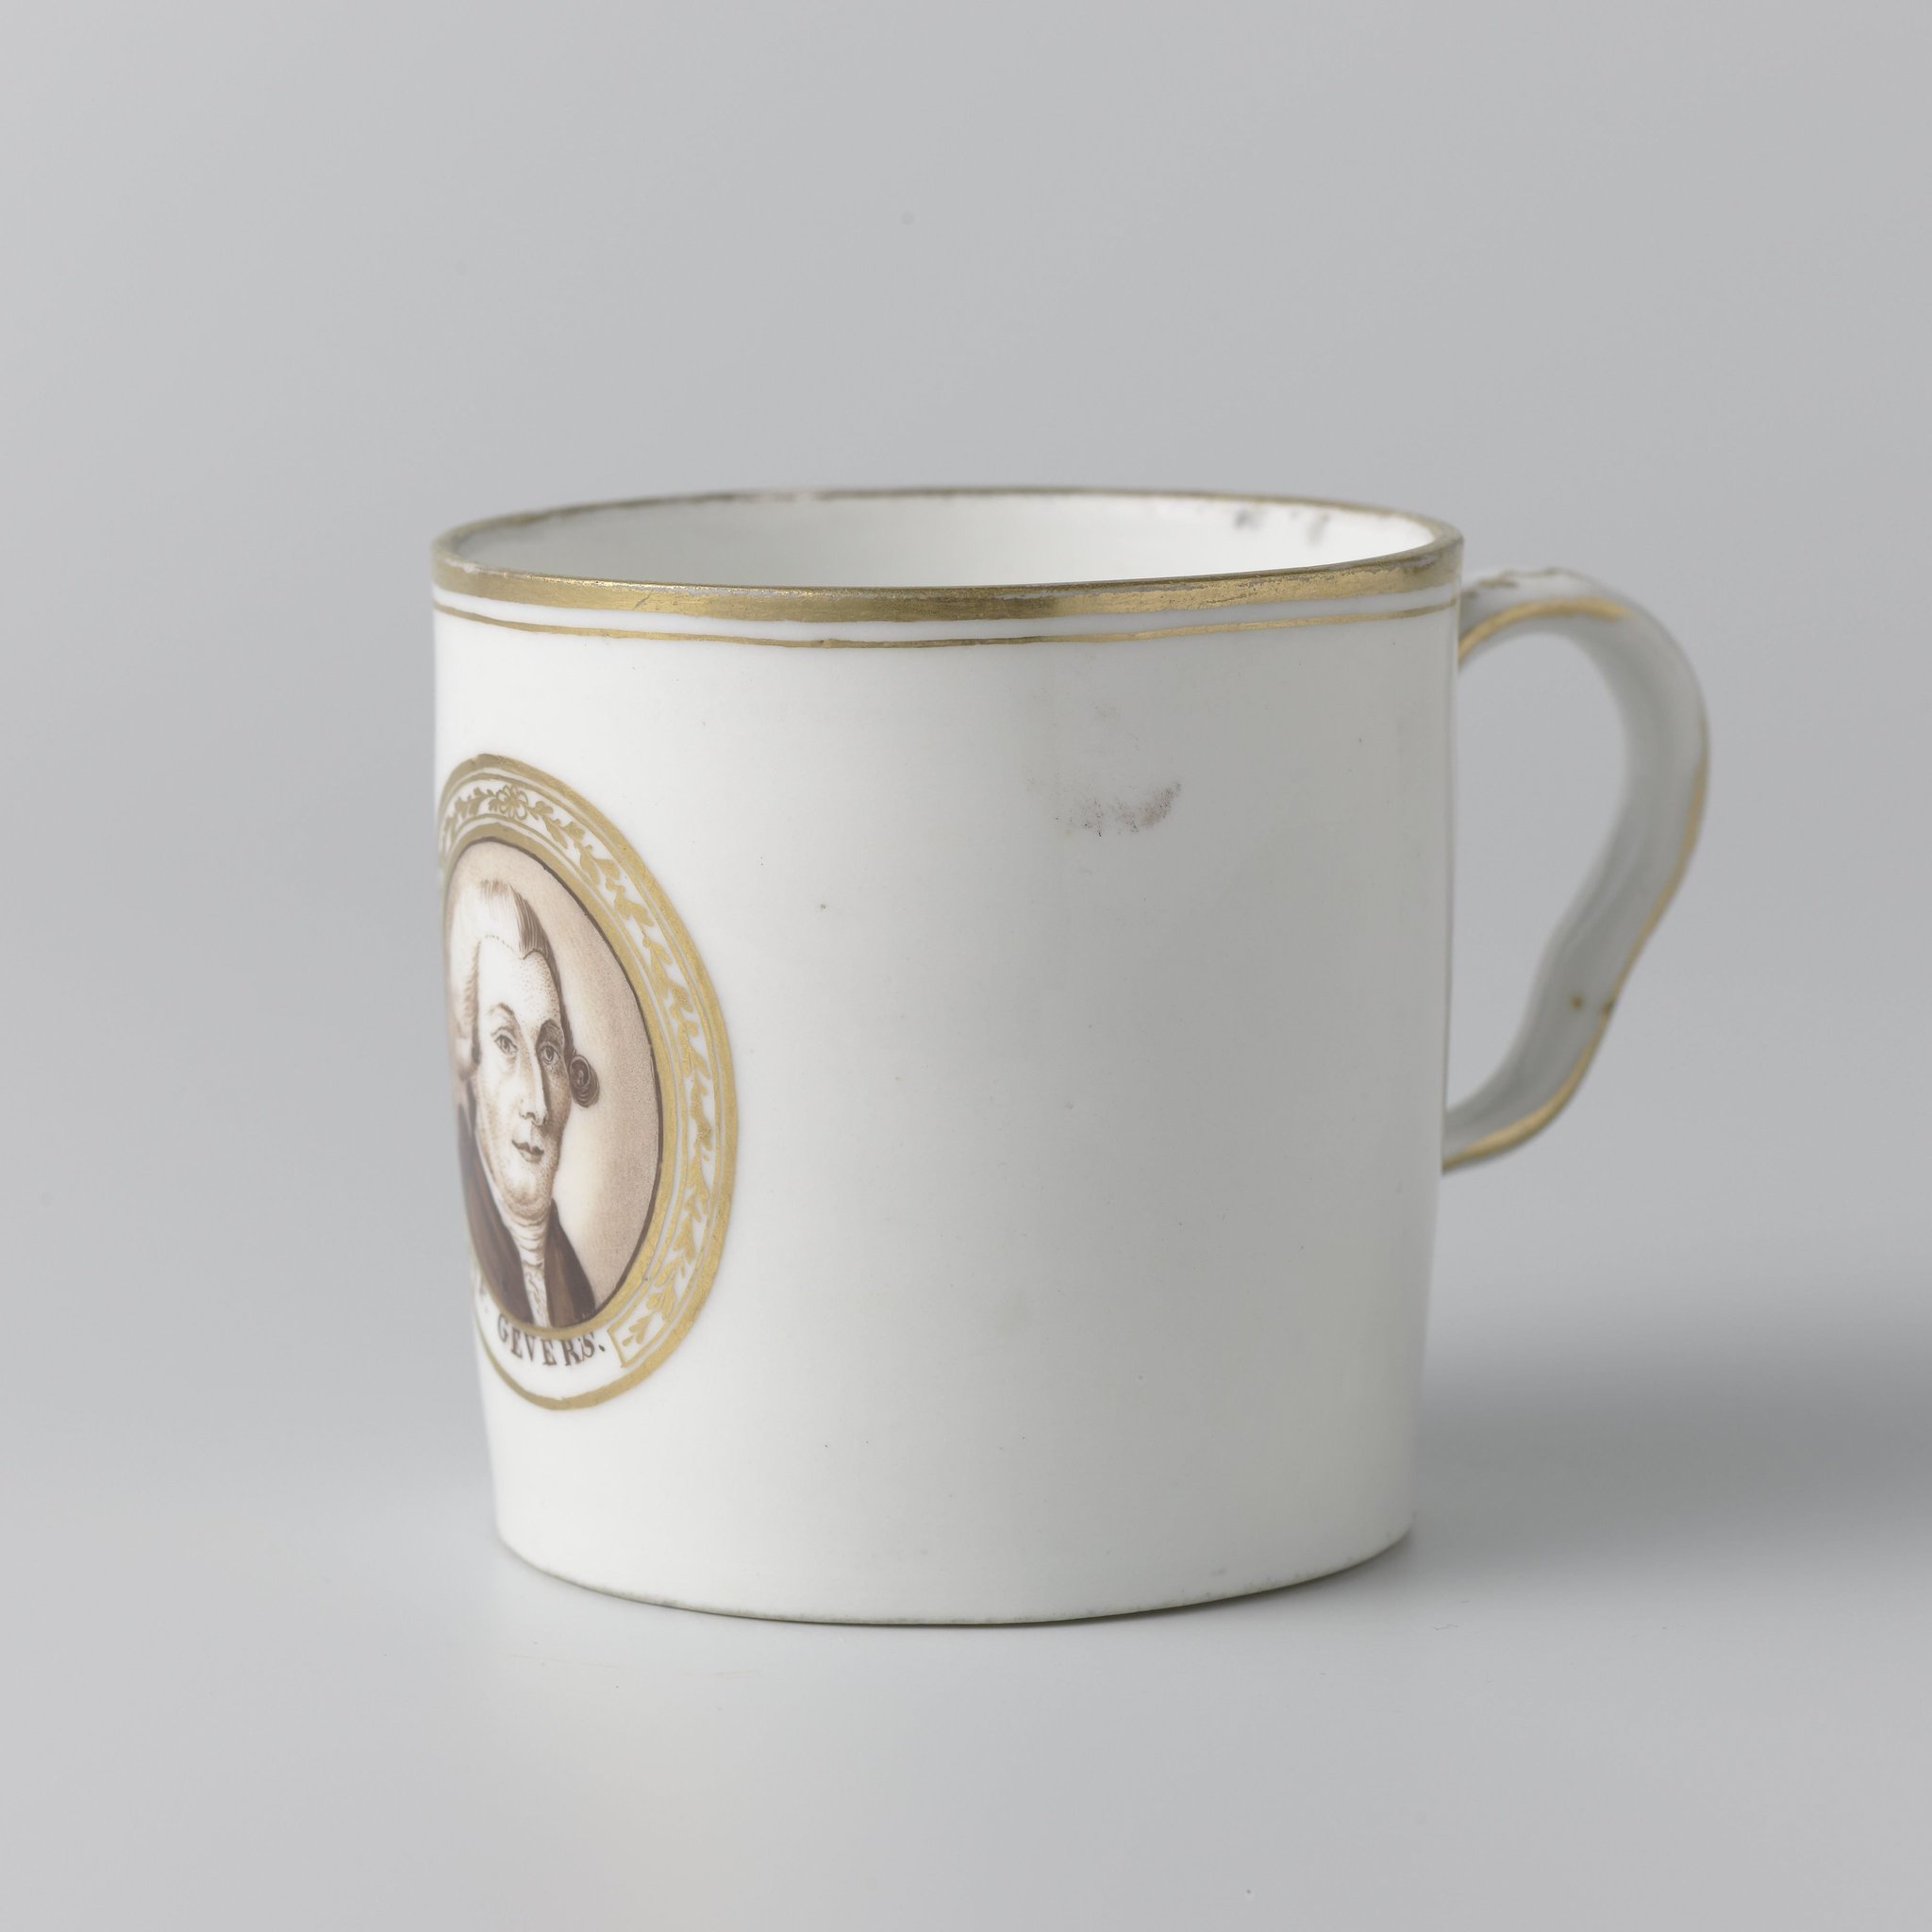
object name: service set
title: Cup with the portrait of P. Gevers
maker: Anonymous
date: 1794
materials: glaze, gold, paint, porcelain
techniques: firing, forming, gilding, turning, vitrification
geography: ilmenau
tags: nieuwland, jurist, baljuw, paulus gevers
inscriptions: mark: ‘103-N/ 9’, inscription: ‘P. GEVERS.’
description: Kop van porselein, beschilderd op het glazuur in sepia en goud. Op de buitenwand een medaillon met een portret. Een band met een bladrank en het opschrift 'P. GEVERS.' om het medaillon. Gouden rand en een bladrank op het oor. Gemerkt op de onderzijde met 103-N en 9.